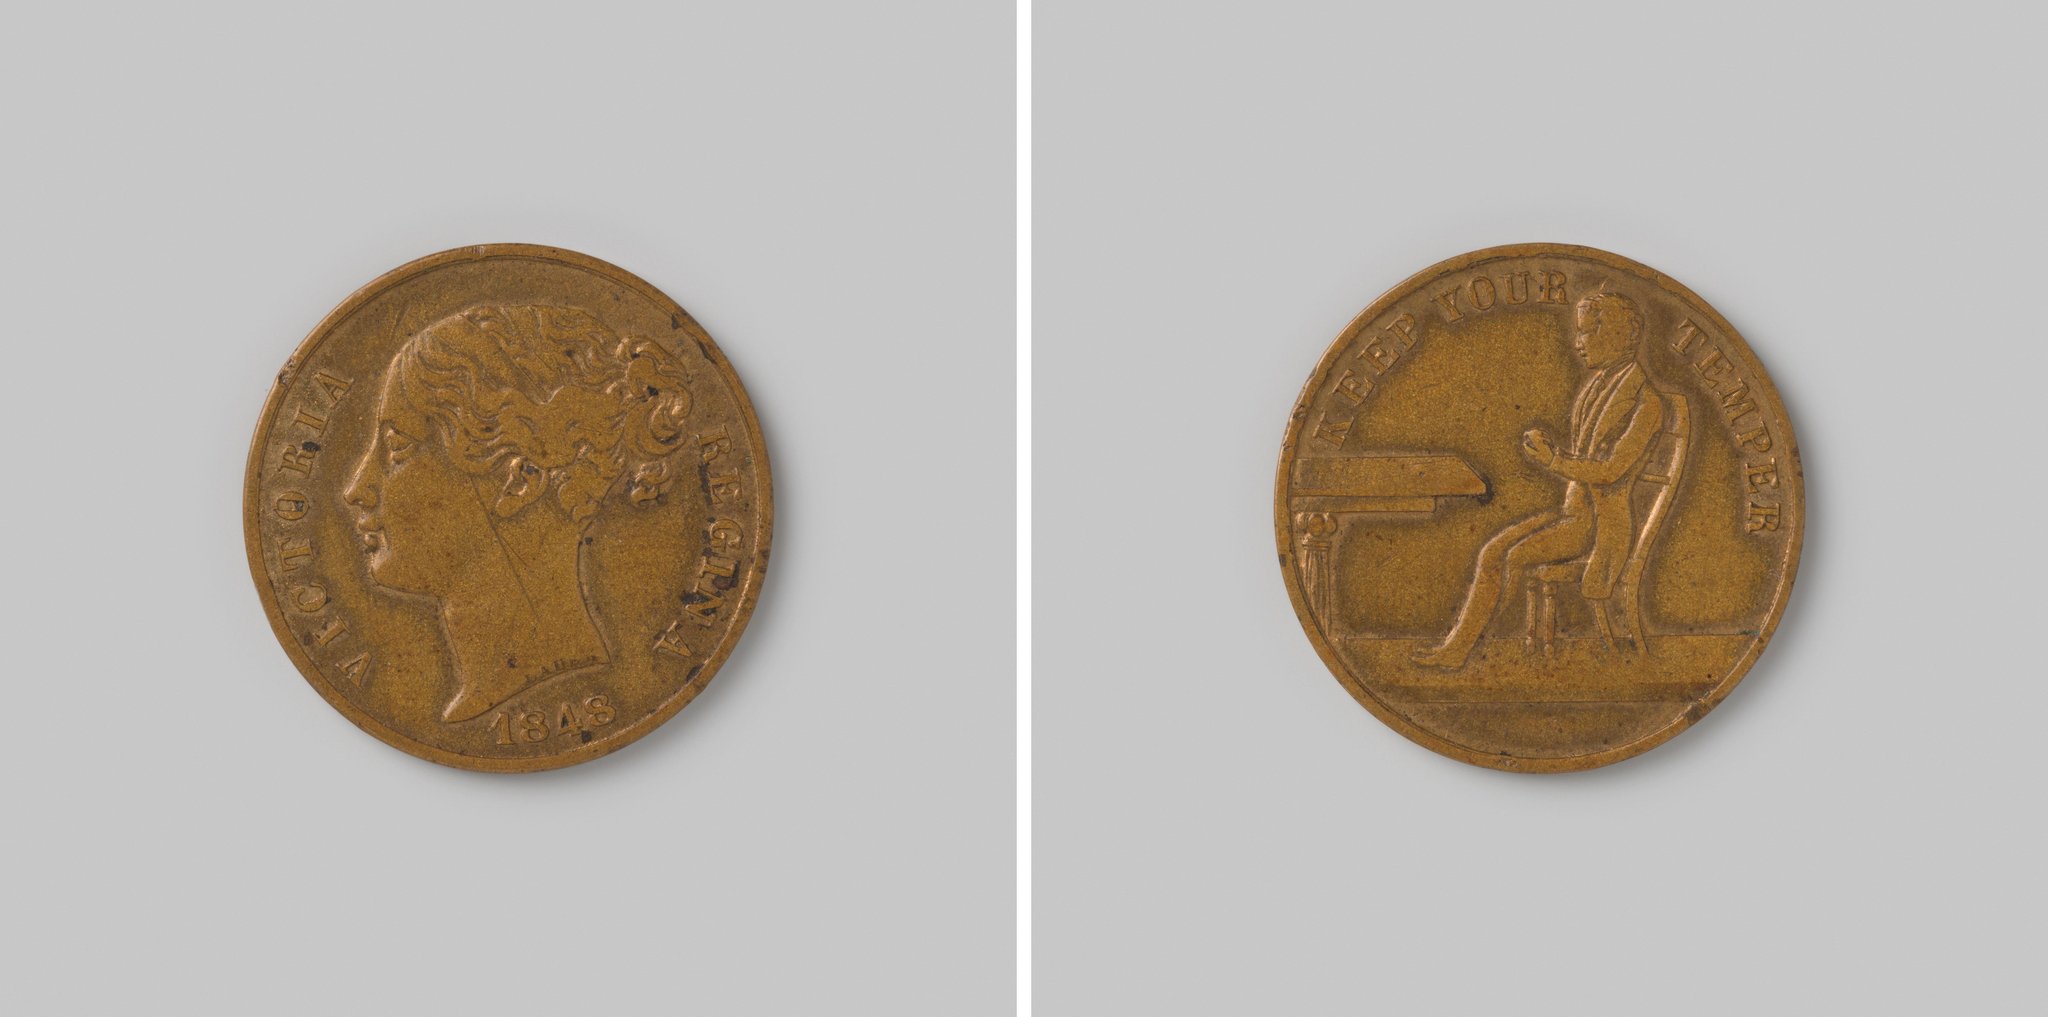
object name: gaming counter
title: Speelpenning voor whist met Koningin Victoria 1848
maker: johann jakob lauer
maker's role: die cutter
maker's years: 1788-1863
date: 1848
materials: brass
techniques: striking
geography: nuremberg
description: Messing penning, op de voorzijde het portret van Victoria naar links met omschrift, op de keerzijde een man naar links gezeten aan tafel, met omschrift.